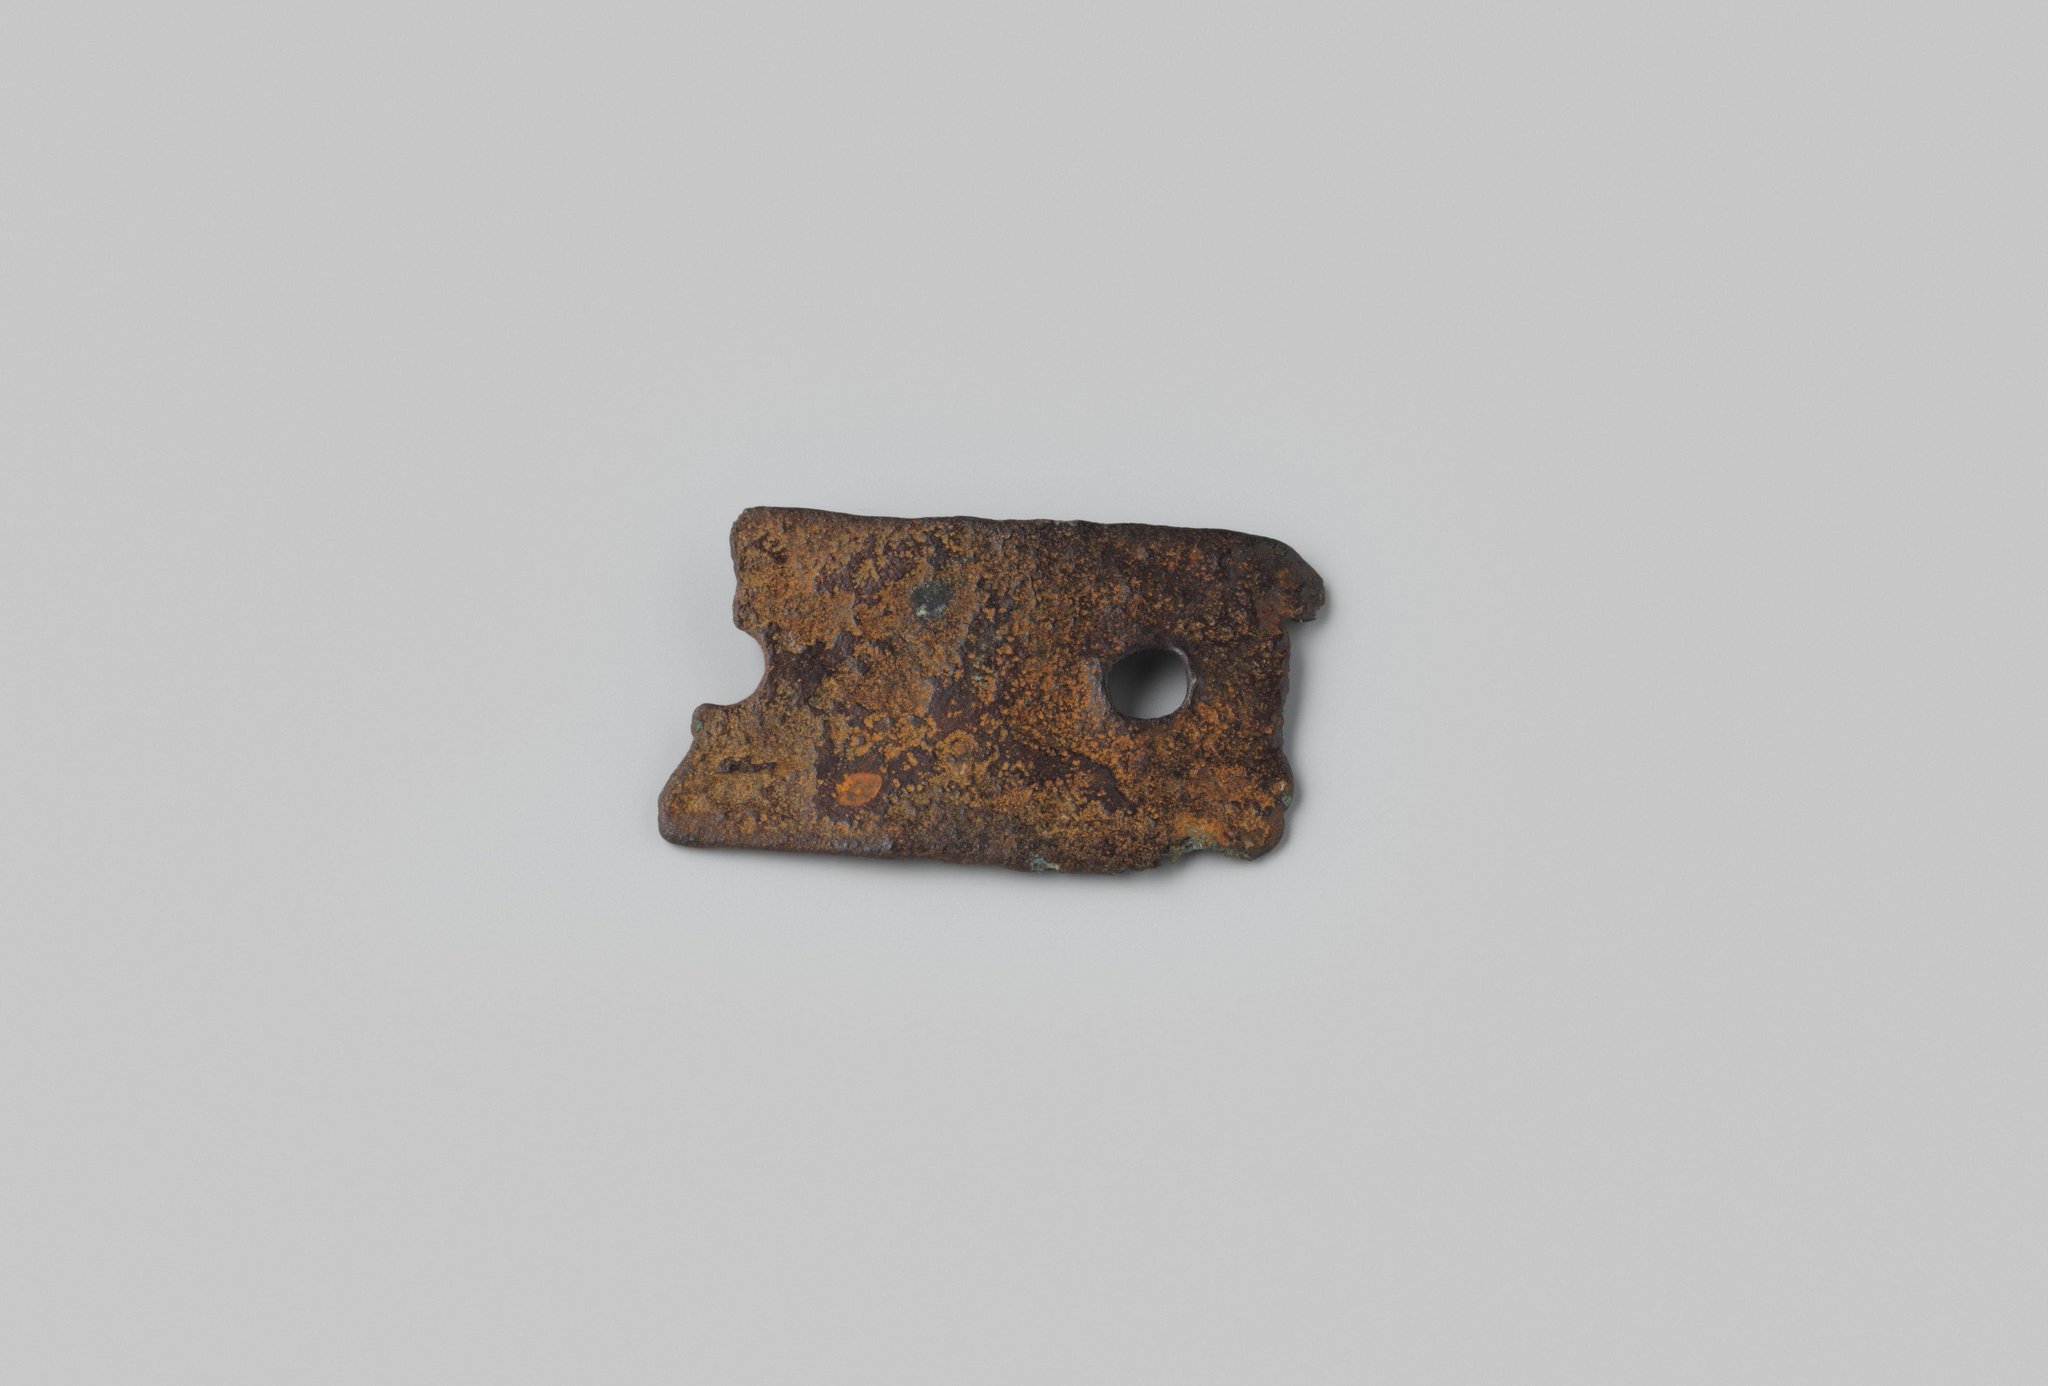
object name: part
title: Onderdeel of hulpstuk afkomstig uit het wrak van de Oost-Indiëvaarder Hollandia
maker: Anonymous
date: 1700-1743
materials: copper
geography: netherlands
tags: verenigde oostindische compagnie, hollandia (schip)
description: Strip-shaped fitting; fragm, sim. 80H947.